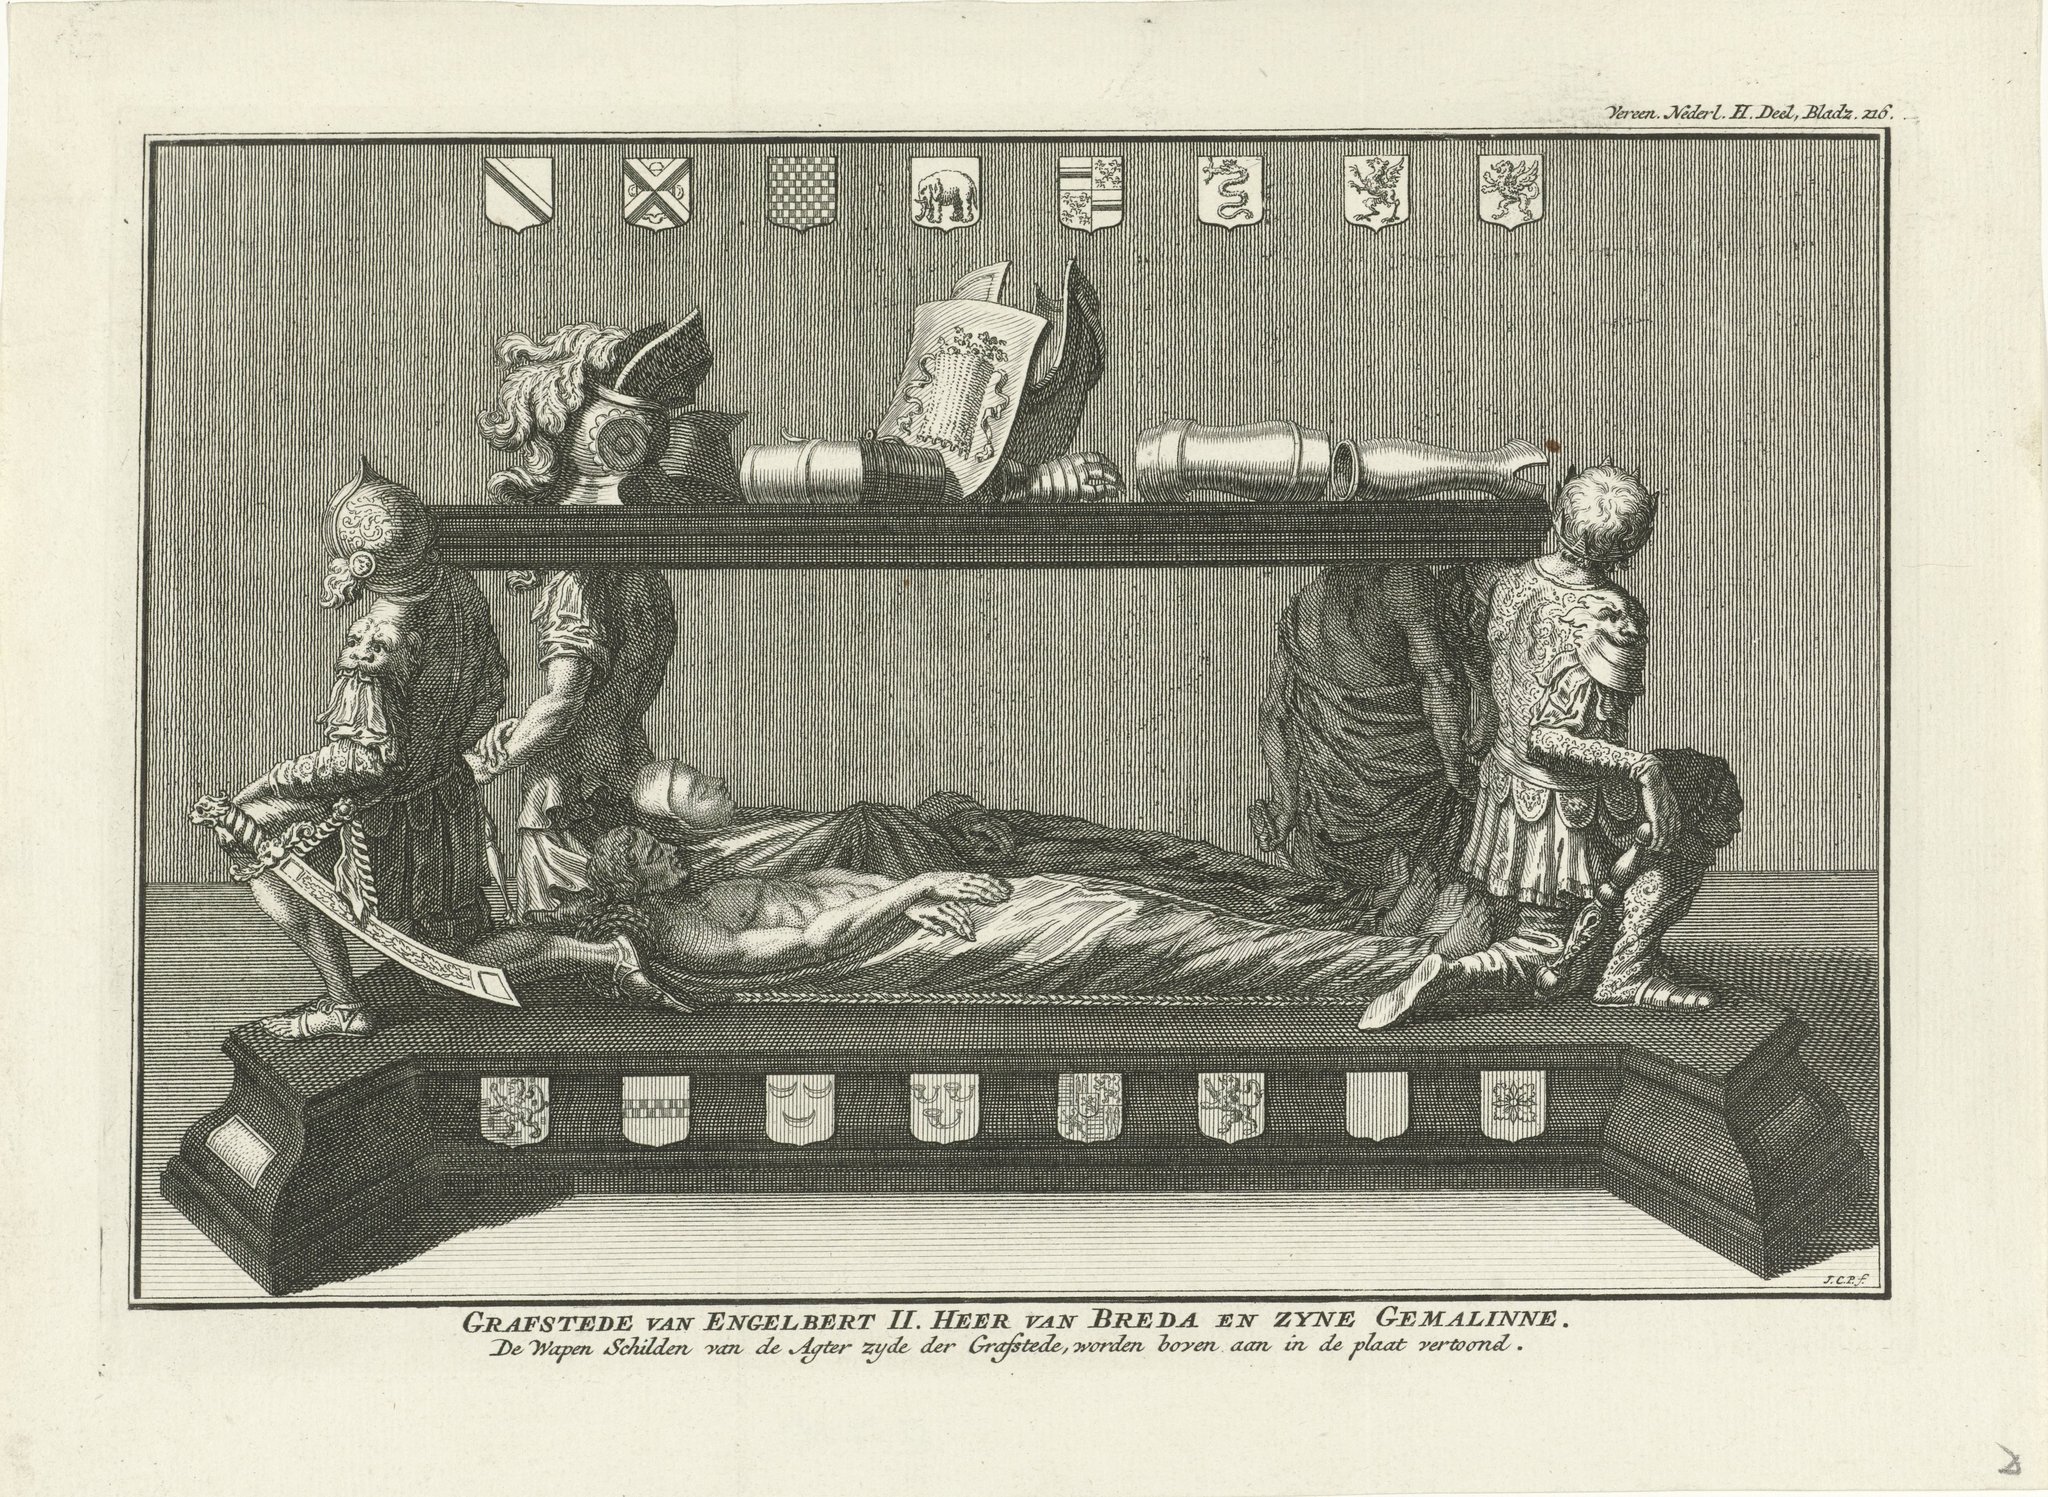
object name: book illustration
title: Grafstede van Engelbert II. Heer van Breda en zyne Gemalinne. De wapen schilden van de agter zyde der grafstede, worden boven aan in de plaat vertoond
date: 1736-1775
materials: paper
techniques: engraving, etching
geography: amsterdam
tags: brussels, grave, tomb, armorial bearing, heraldry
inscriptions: collector's mark: Lugt 2228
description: Prent komt voor in: Wagenaar, Jan. Tegenwoordige staat der Vereenigde Nederlanden, tweede deel. Vervattende eene beschryving der Generaliteits Landen (…) / Hedendaagsche historie, of tegenwoordige staat van alle volkeren; XIIde deel (…). Amsterdam: Isaak Tirion, 1740, p. 216.